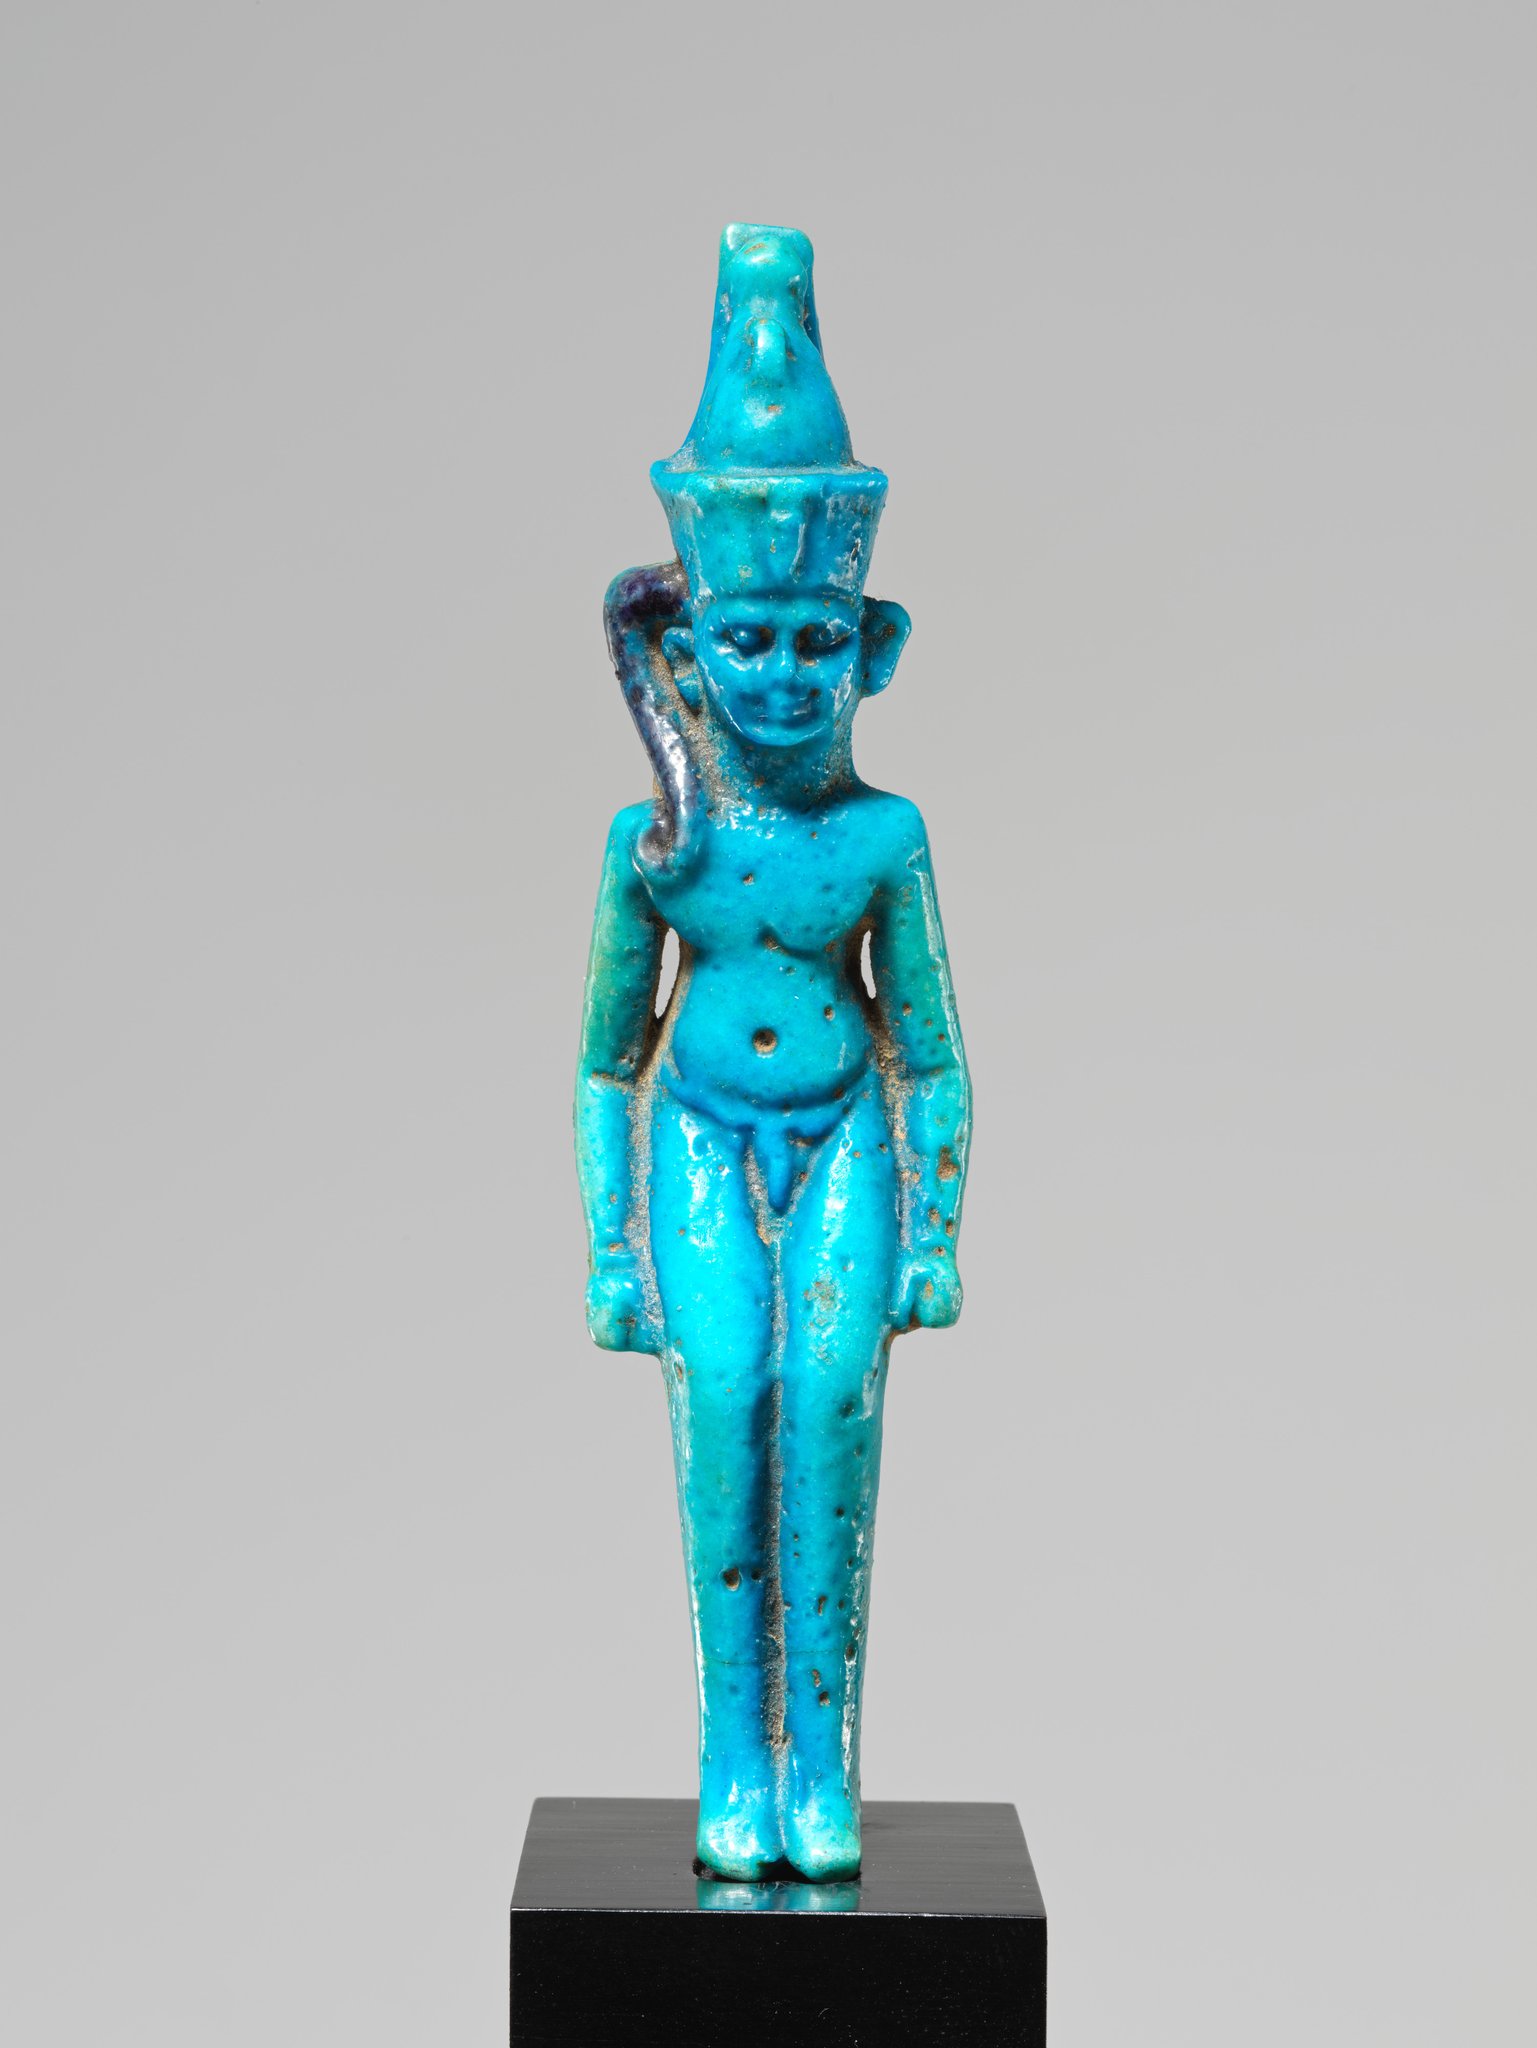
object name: amulet, harpokrates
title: Harpokrates Amulet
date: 1086 BCE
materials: faience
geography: egypt